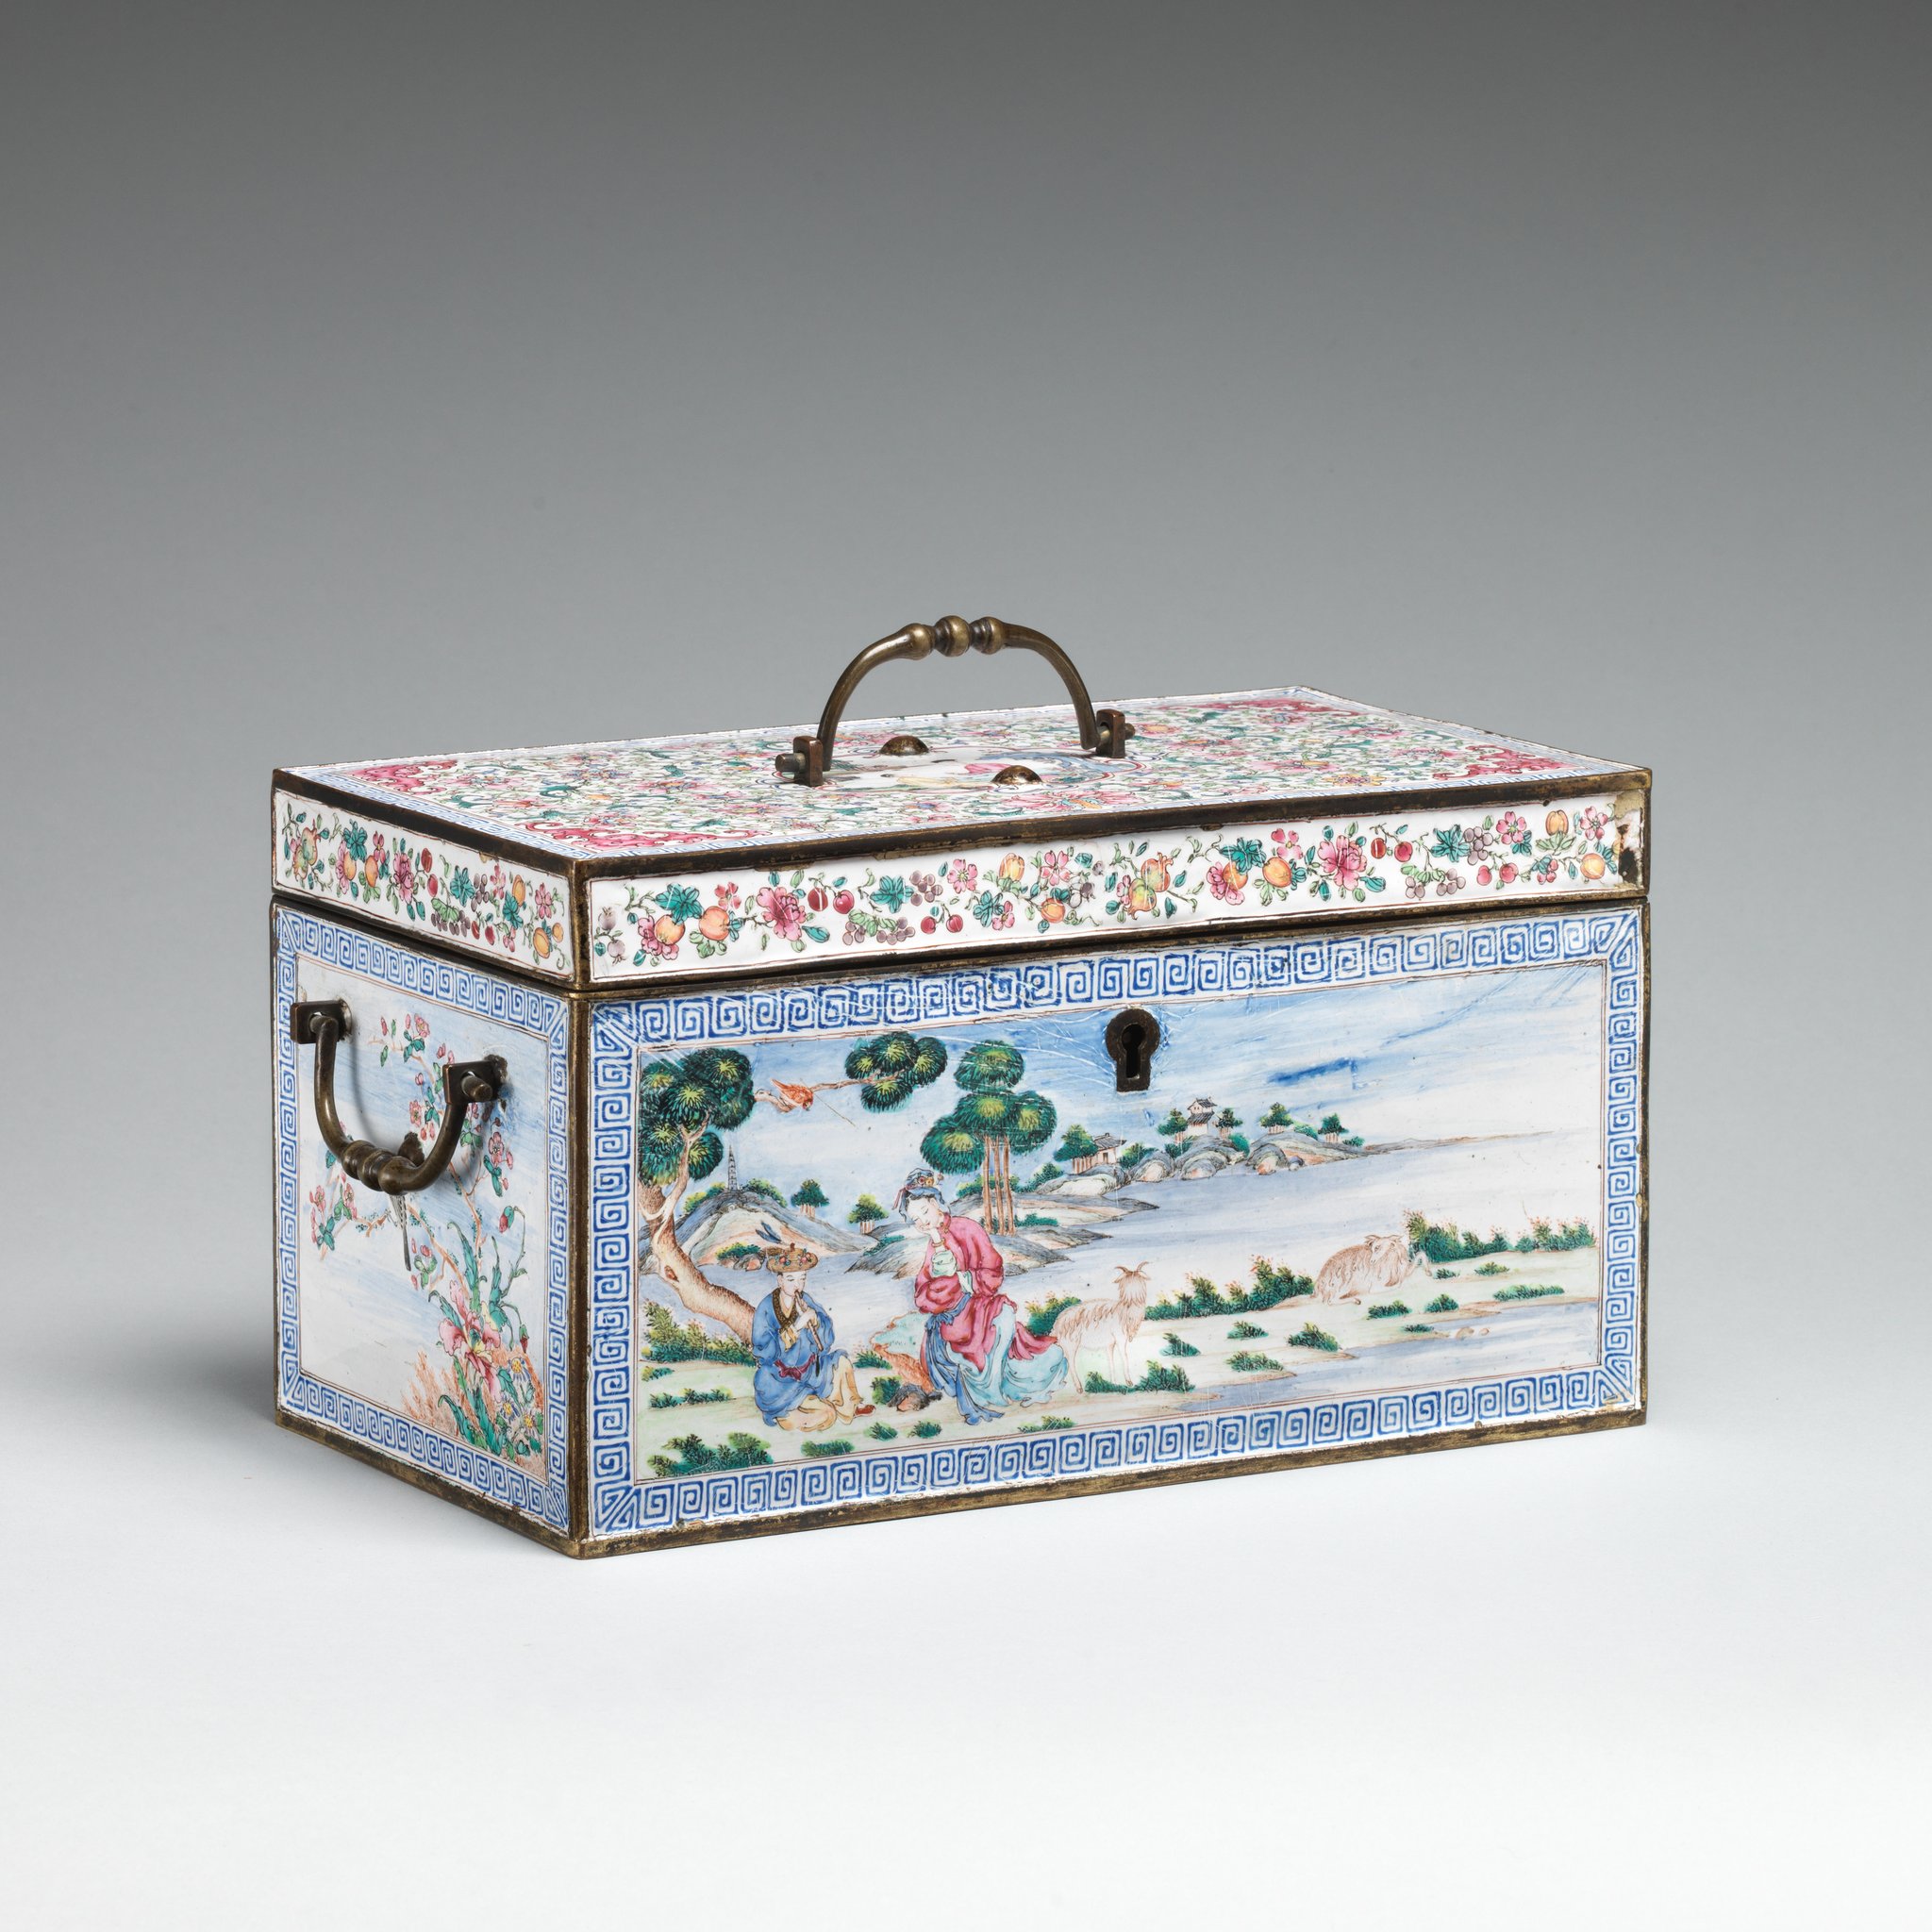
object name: coffret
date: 1730-1760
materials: brass, copper, enamel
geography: china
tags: animals,men,women,landscapes